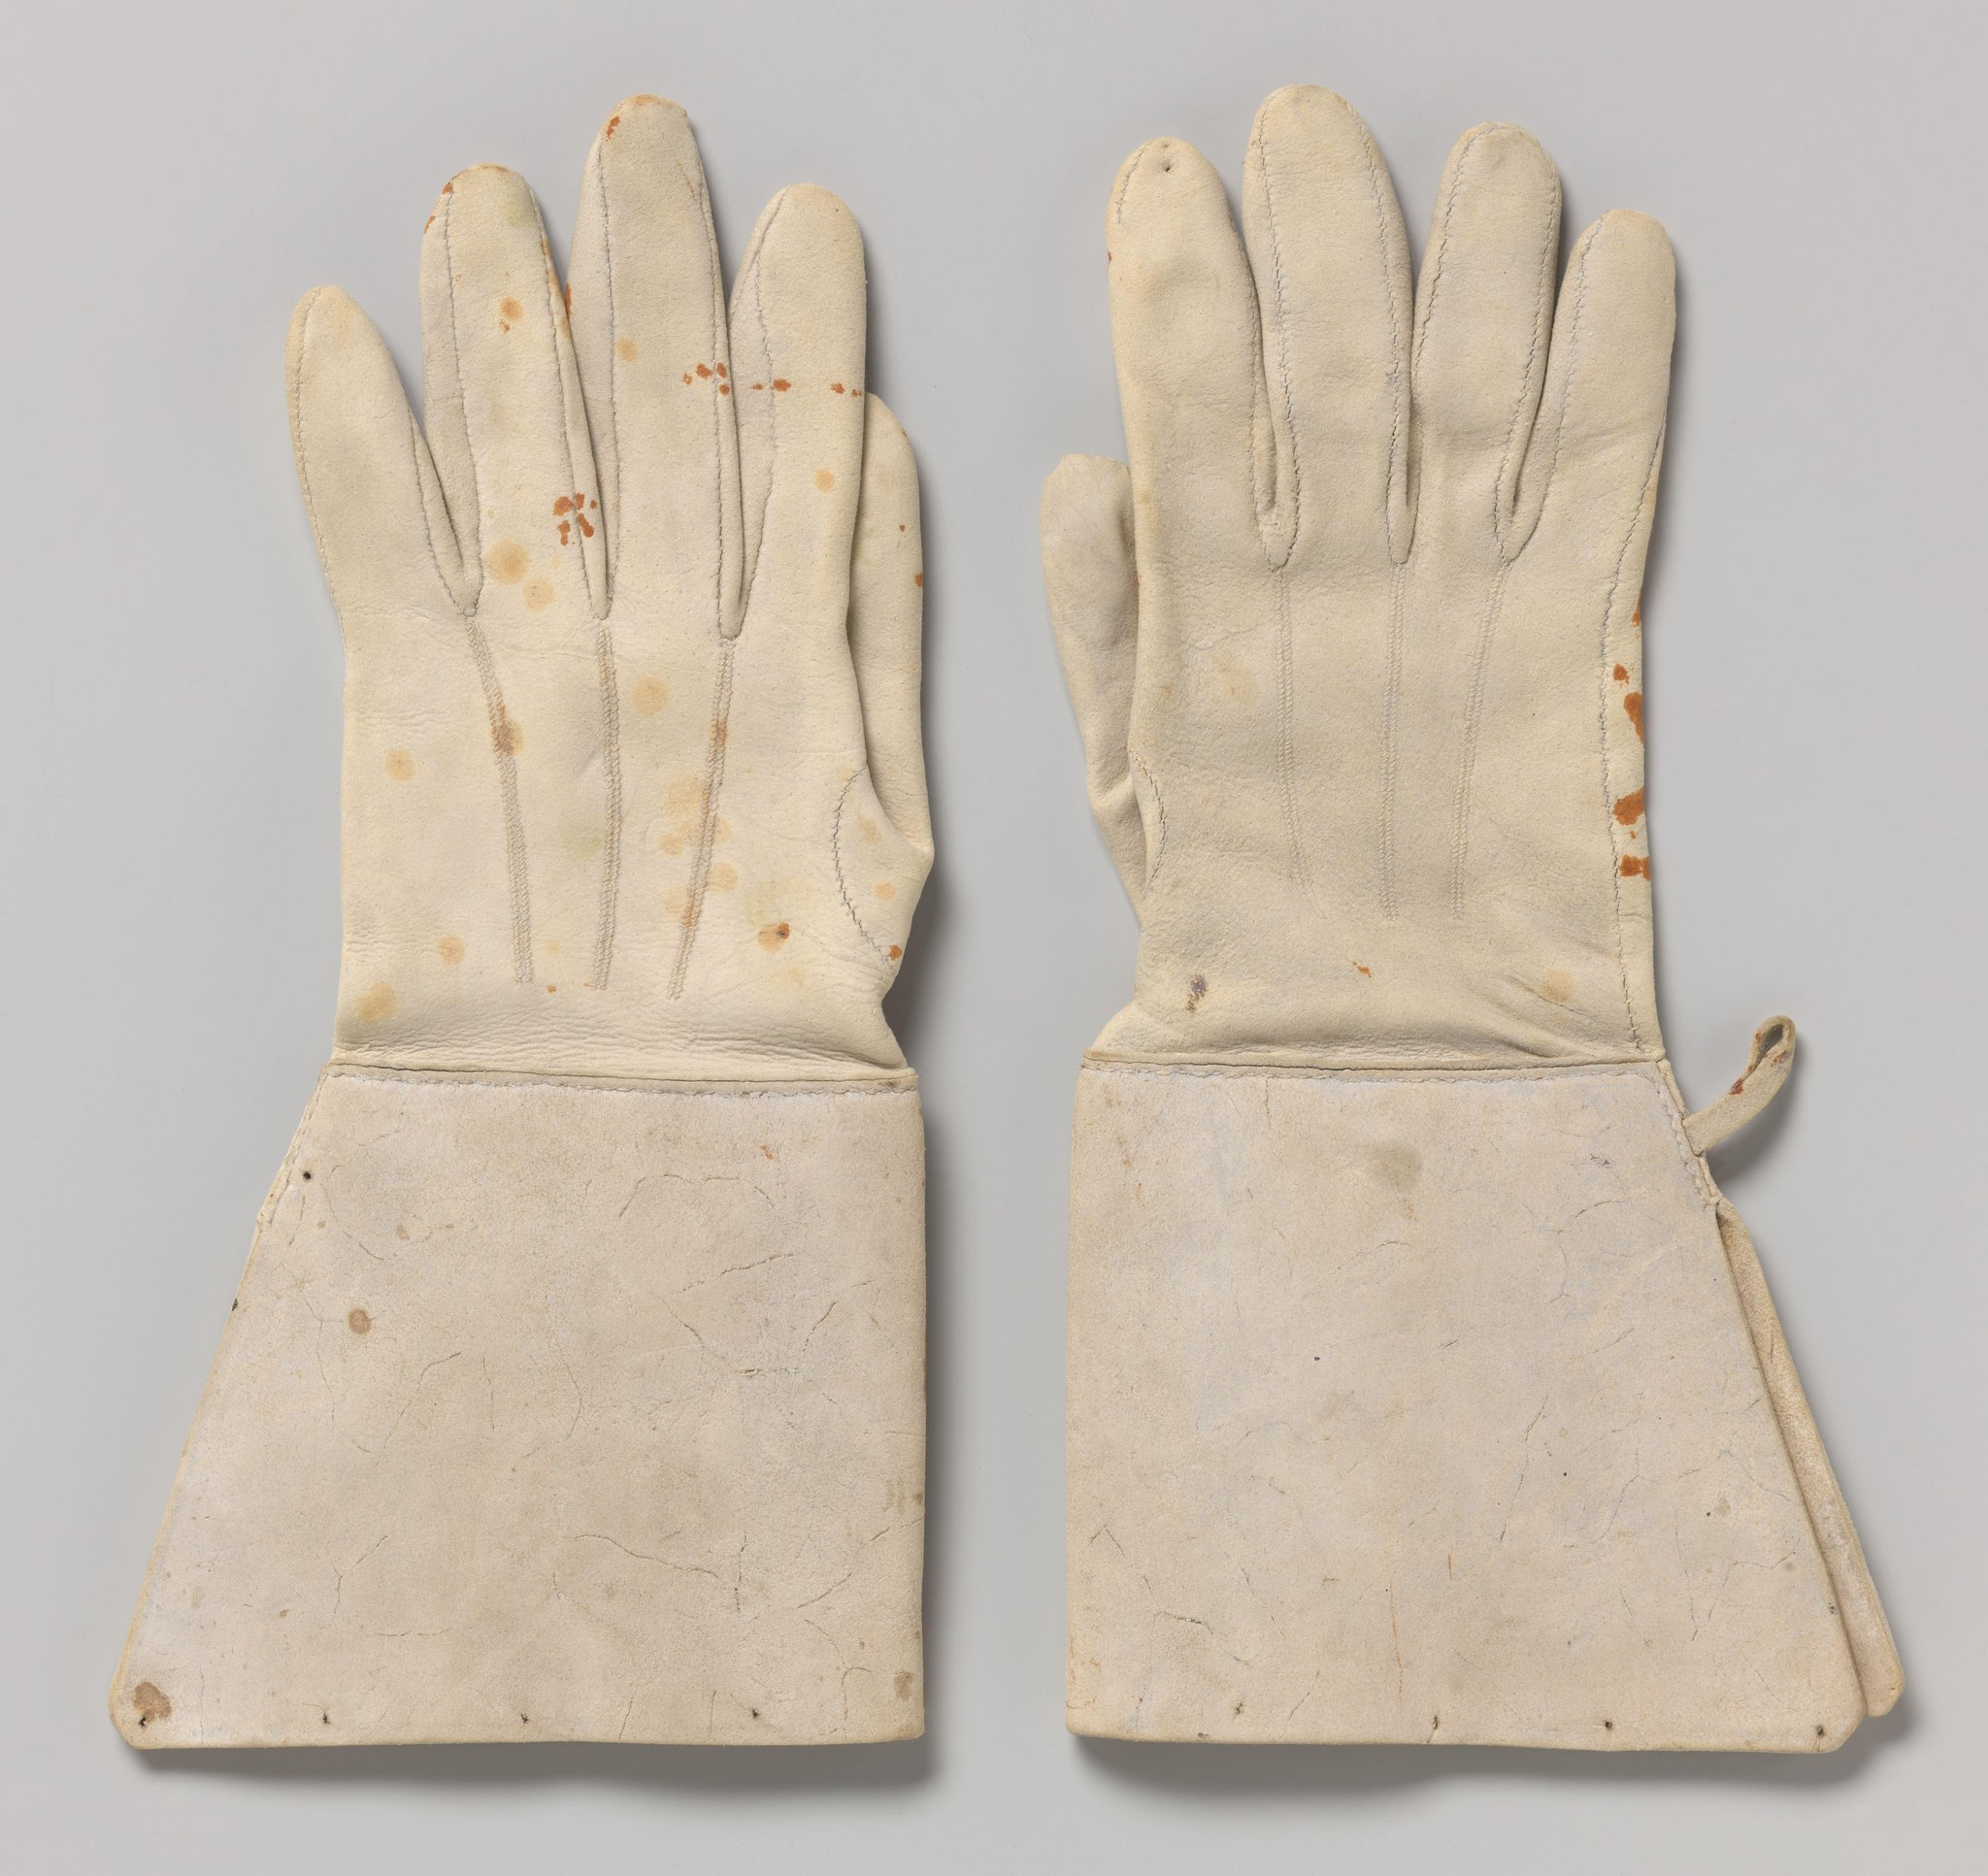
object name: glove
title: Paar handschoenen behorend tot de uitrusting van een sappeur van de 1e Afdeling Noord-Hollandse Schutterij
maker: Anonymous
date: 1800-1830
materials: leather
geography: netherlands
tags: noord-hollandse schutterij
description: Een paar handschoenen van wit leer. Afkomstig van de uitrusting van een sappeur van de 1e Afdeling Noord-Hollandse Schutterij.